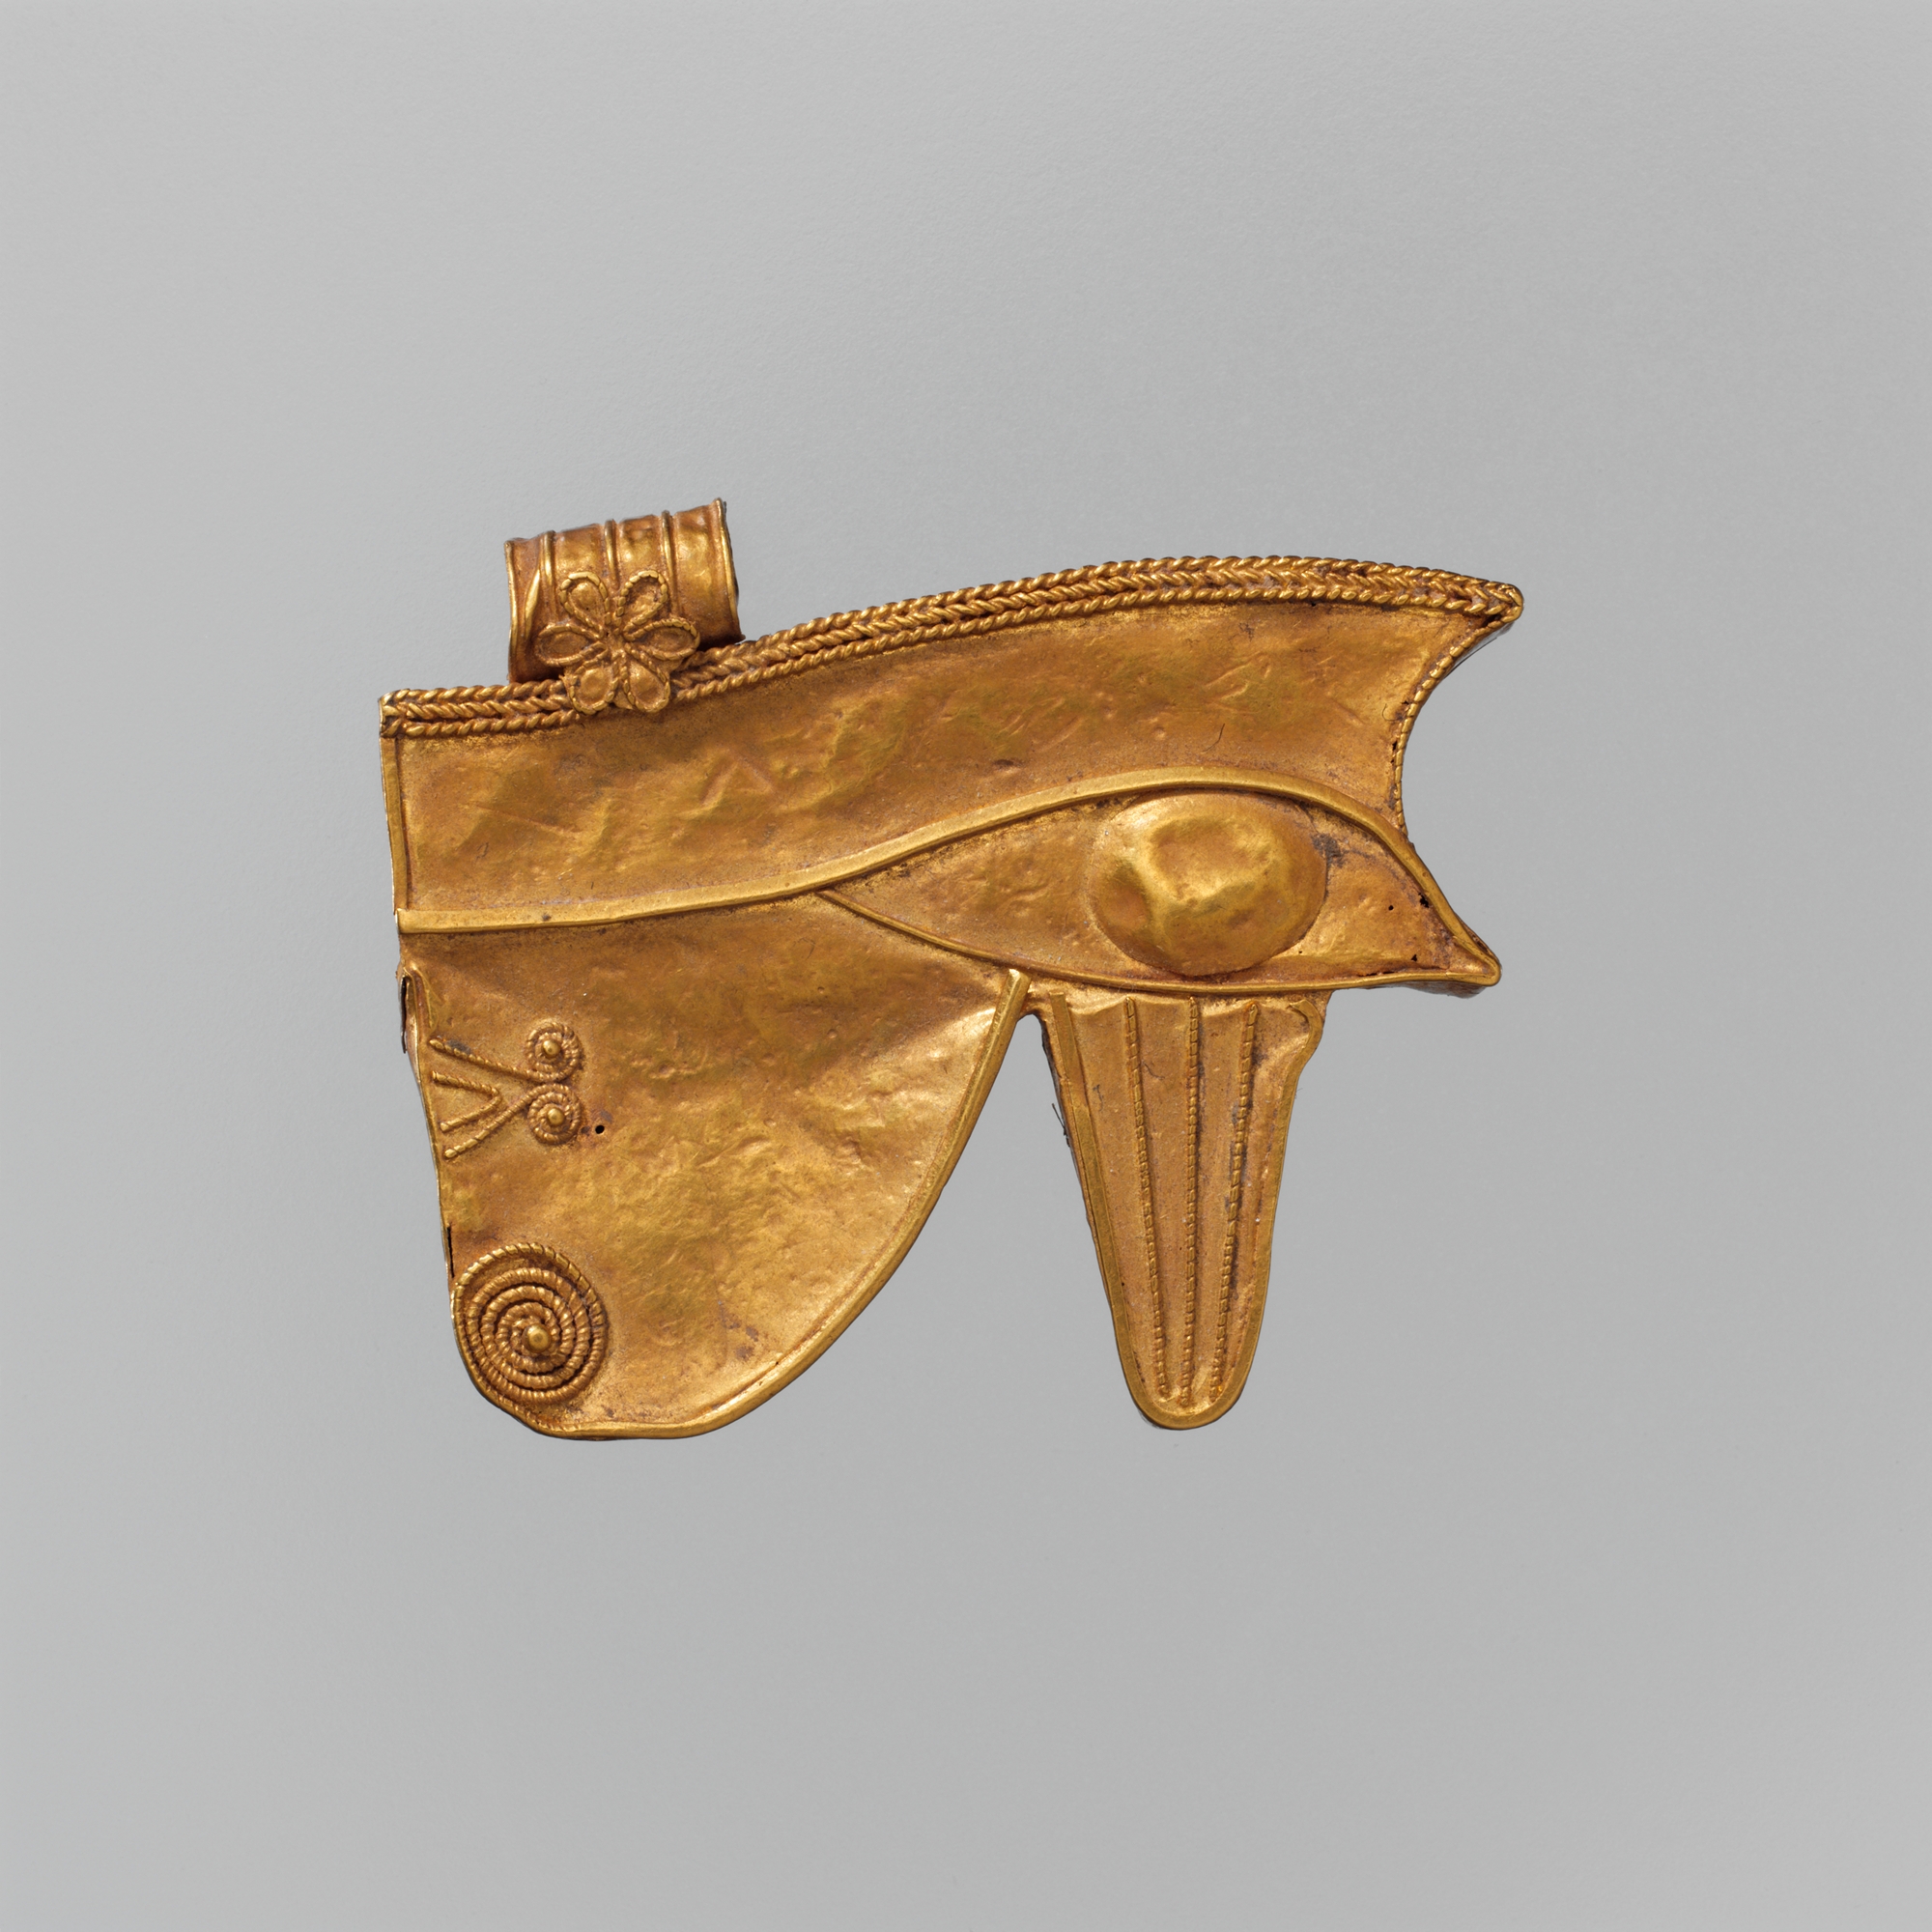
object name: amulet, wedjat eye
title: Wedjat Eye Amulet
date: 332-330 BCE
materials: gold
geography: egypt